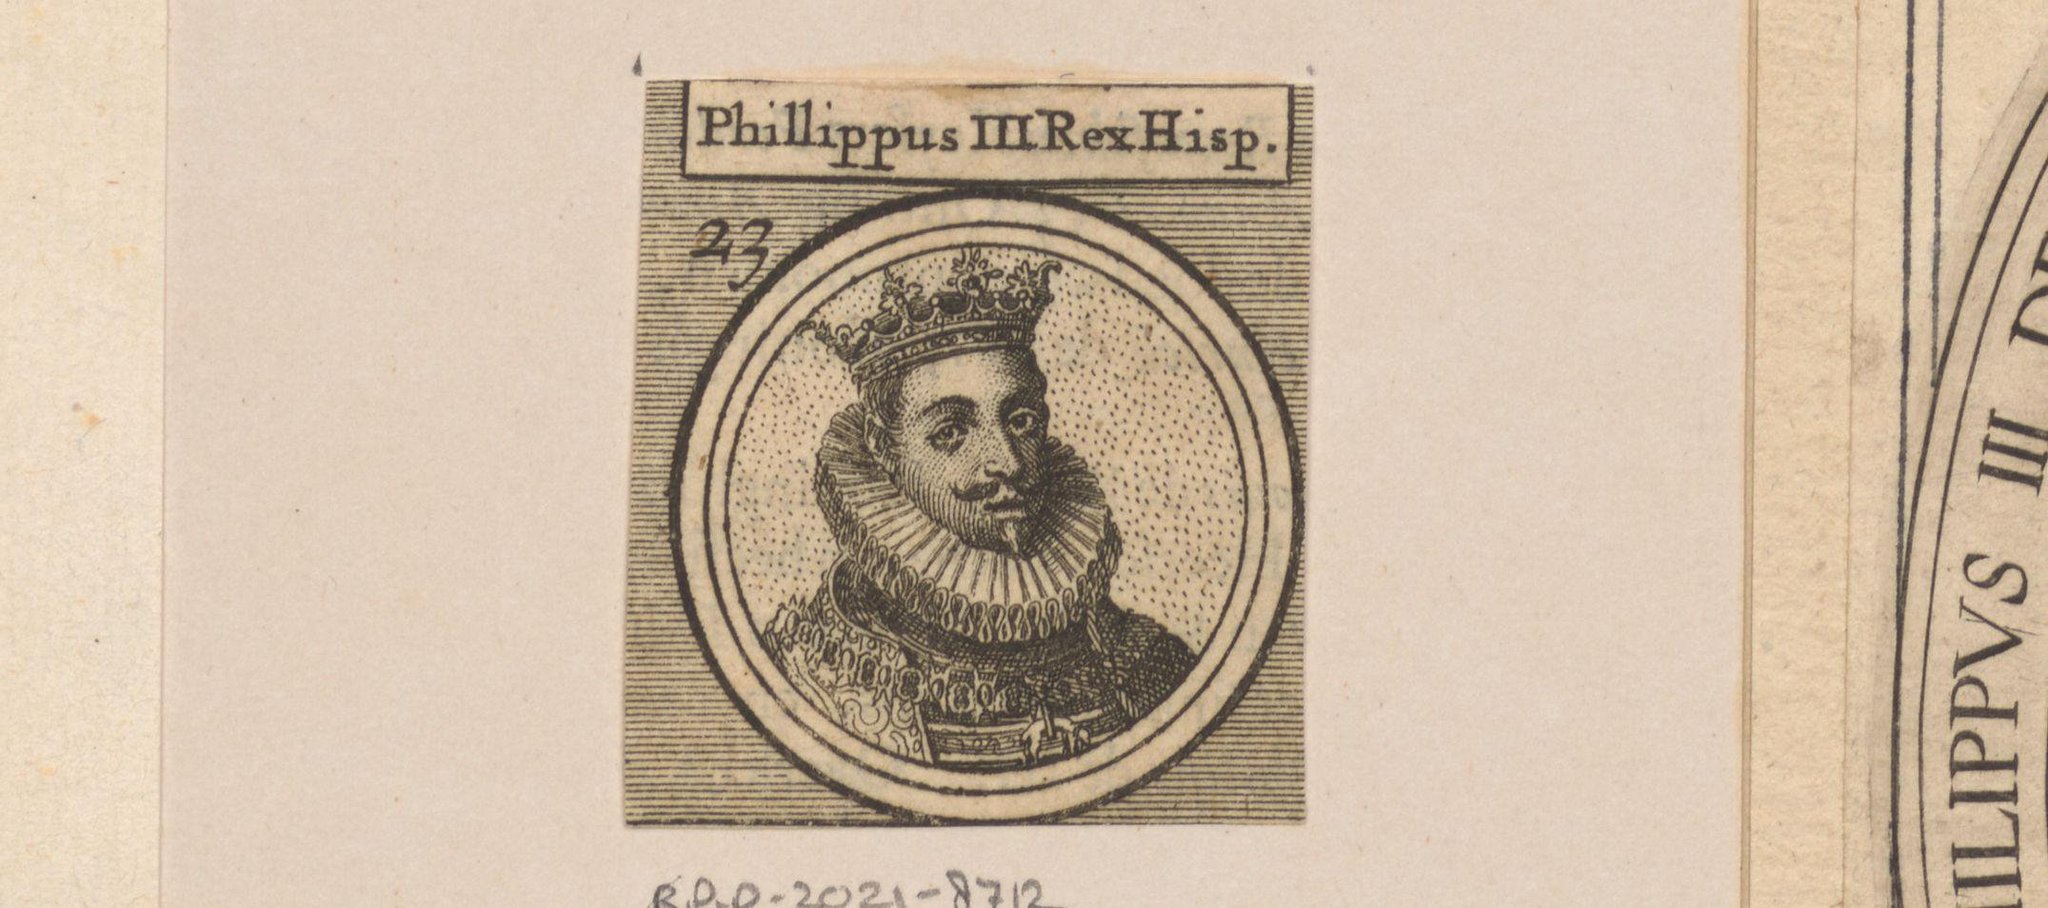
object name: print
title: Portret van Filips III, koning van Spanje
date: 1698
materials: paper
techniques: etching, letterpress printing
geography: leiden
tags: filips iii (koning van spanje), historical persons, knighthood order of the golden fleece, insignia and symbols of sovereignty (crown, diadem, sceptre, orb, seal, standard, cloak, pectoral)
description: Prent uit: Gottfried, Johann Ludwig. Historische kronyck; vervattende een nauwkeurige en volkomene beschrijvingh der aldergedenckwaerdigste geschiedenissen des weerelds, van den aenvangh der scheppingh tot op 't jaer Christi 1576. Leiden: Pieter van der Aa, 1698.